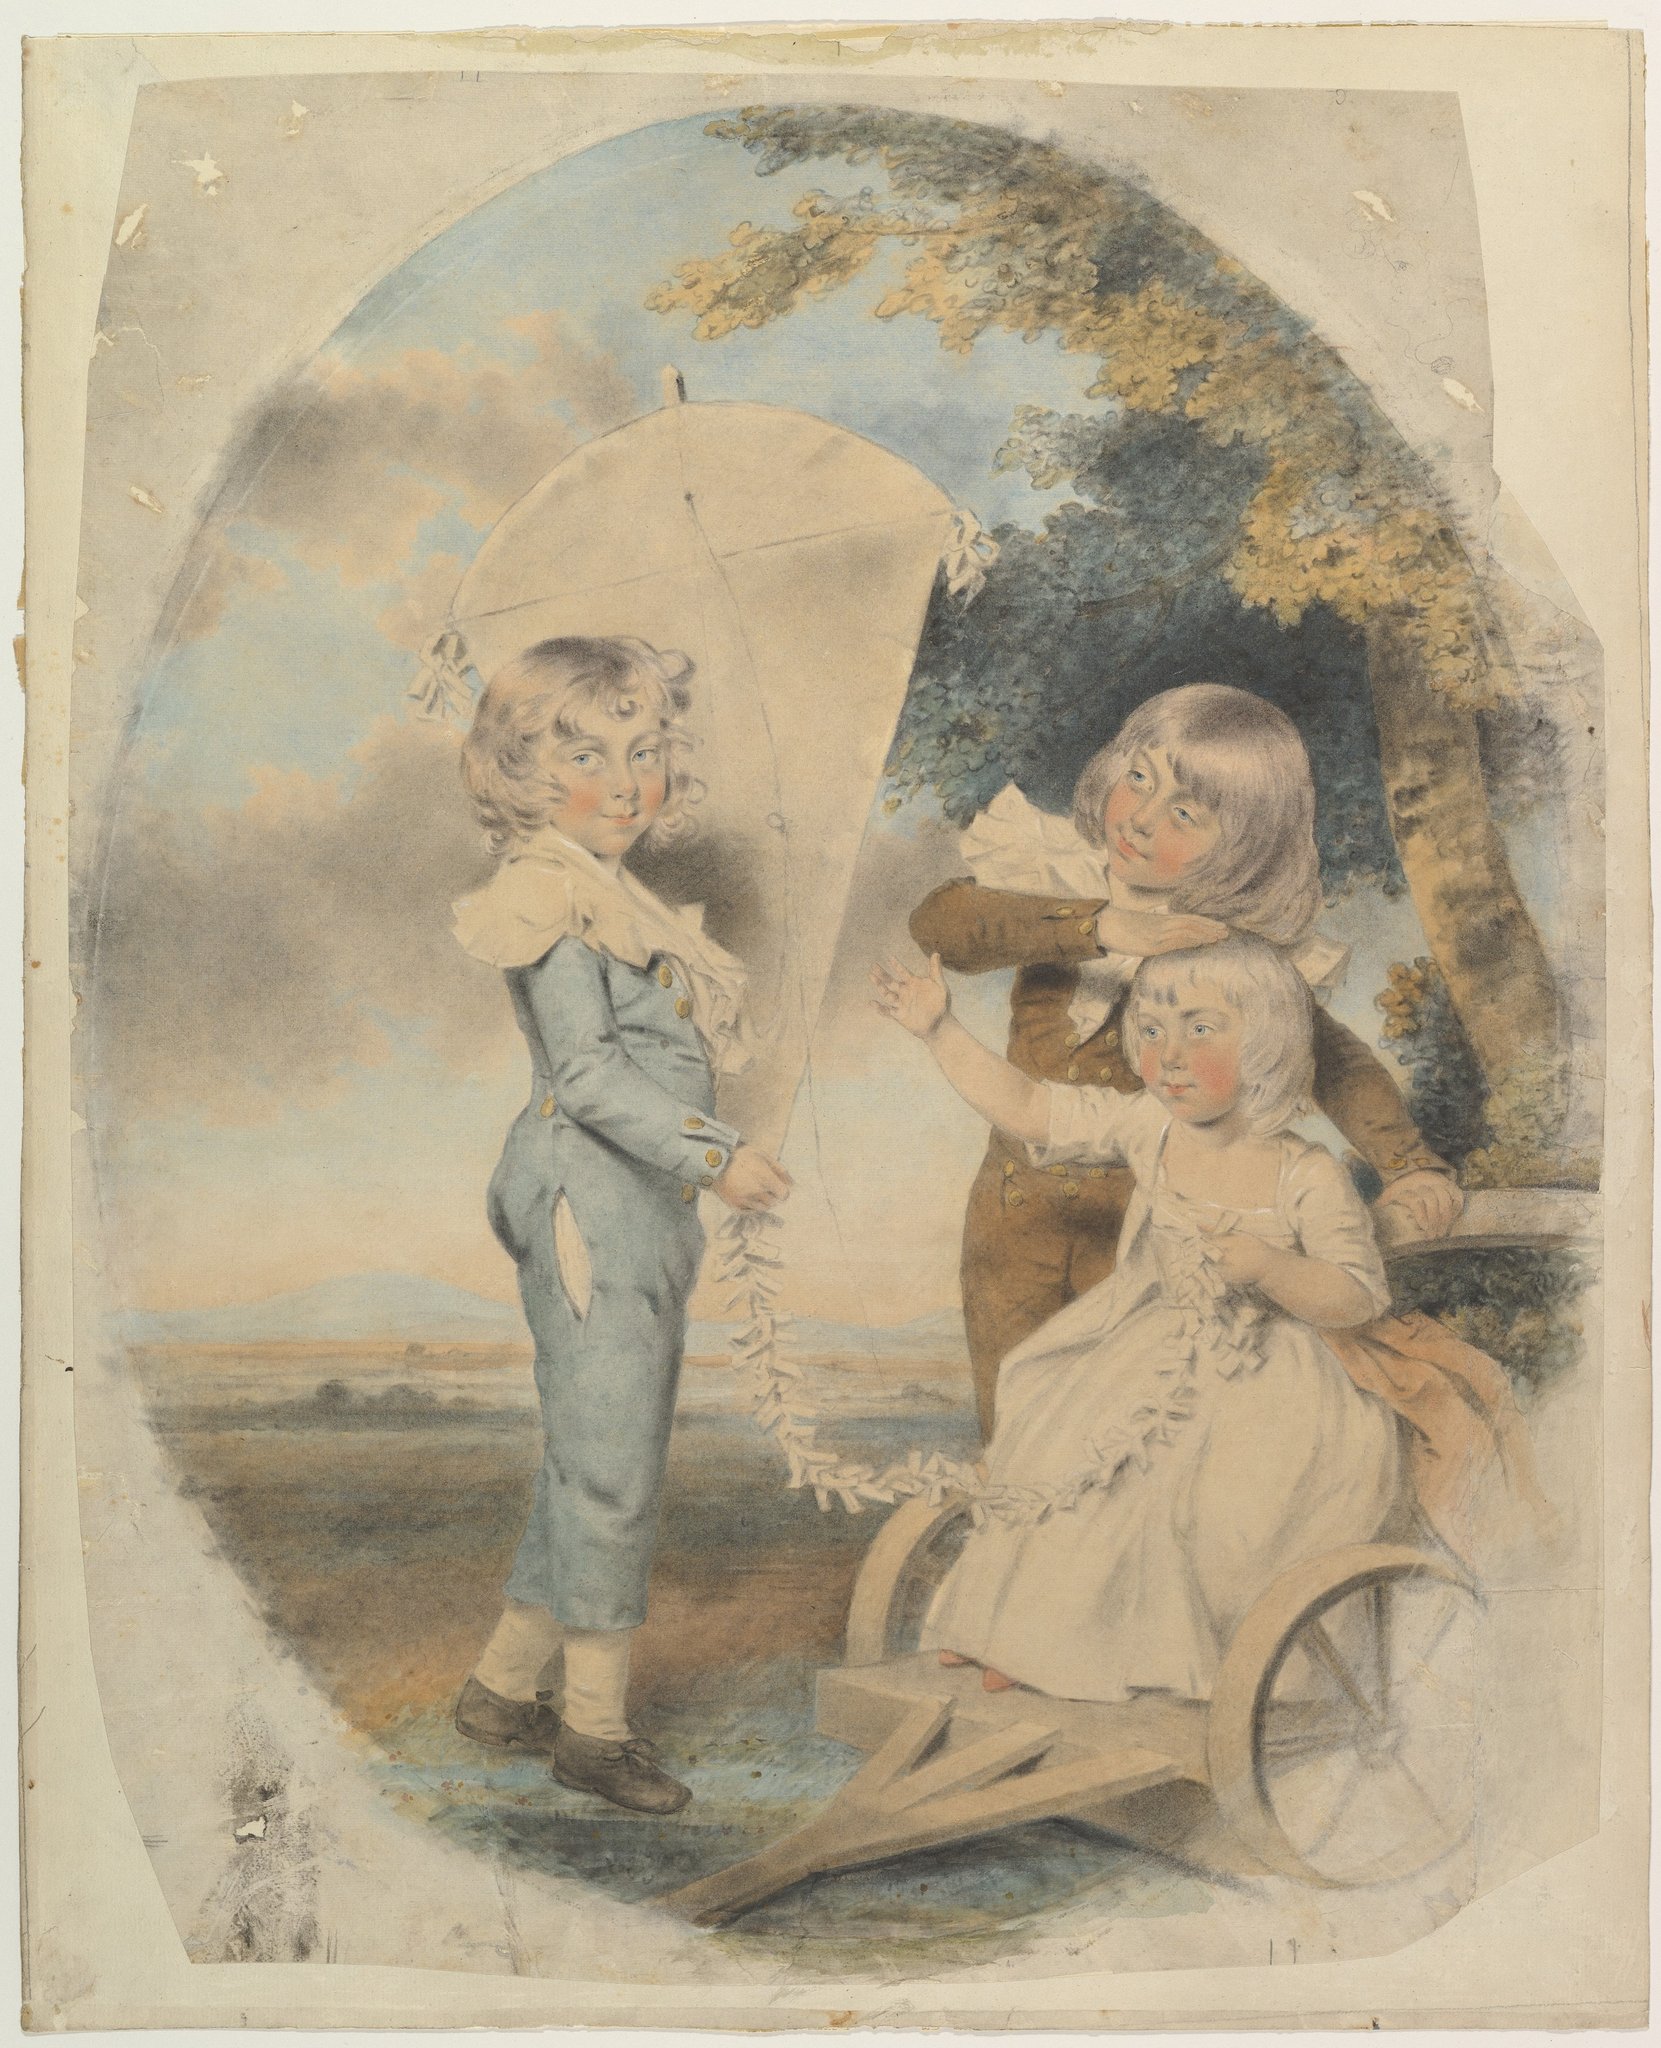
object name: drawing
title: The Dyson Children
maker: john downman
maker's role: artist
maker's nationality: british, welsh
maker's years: 1749-1824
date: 1787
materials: chalk, graphite, watercolor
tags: children,boys,kites